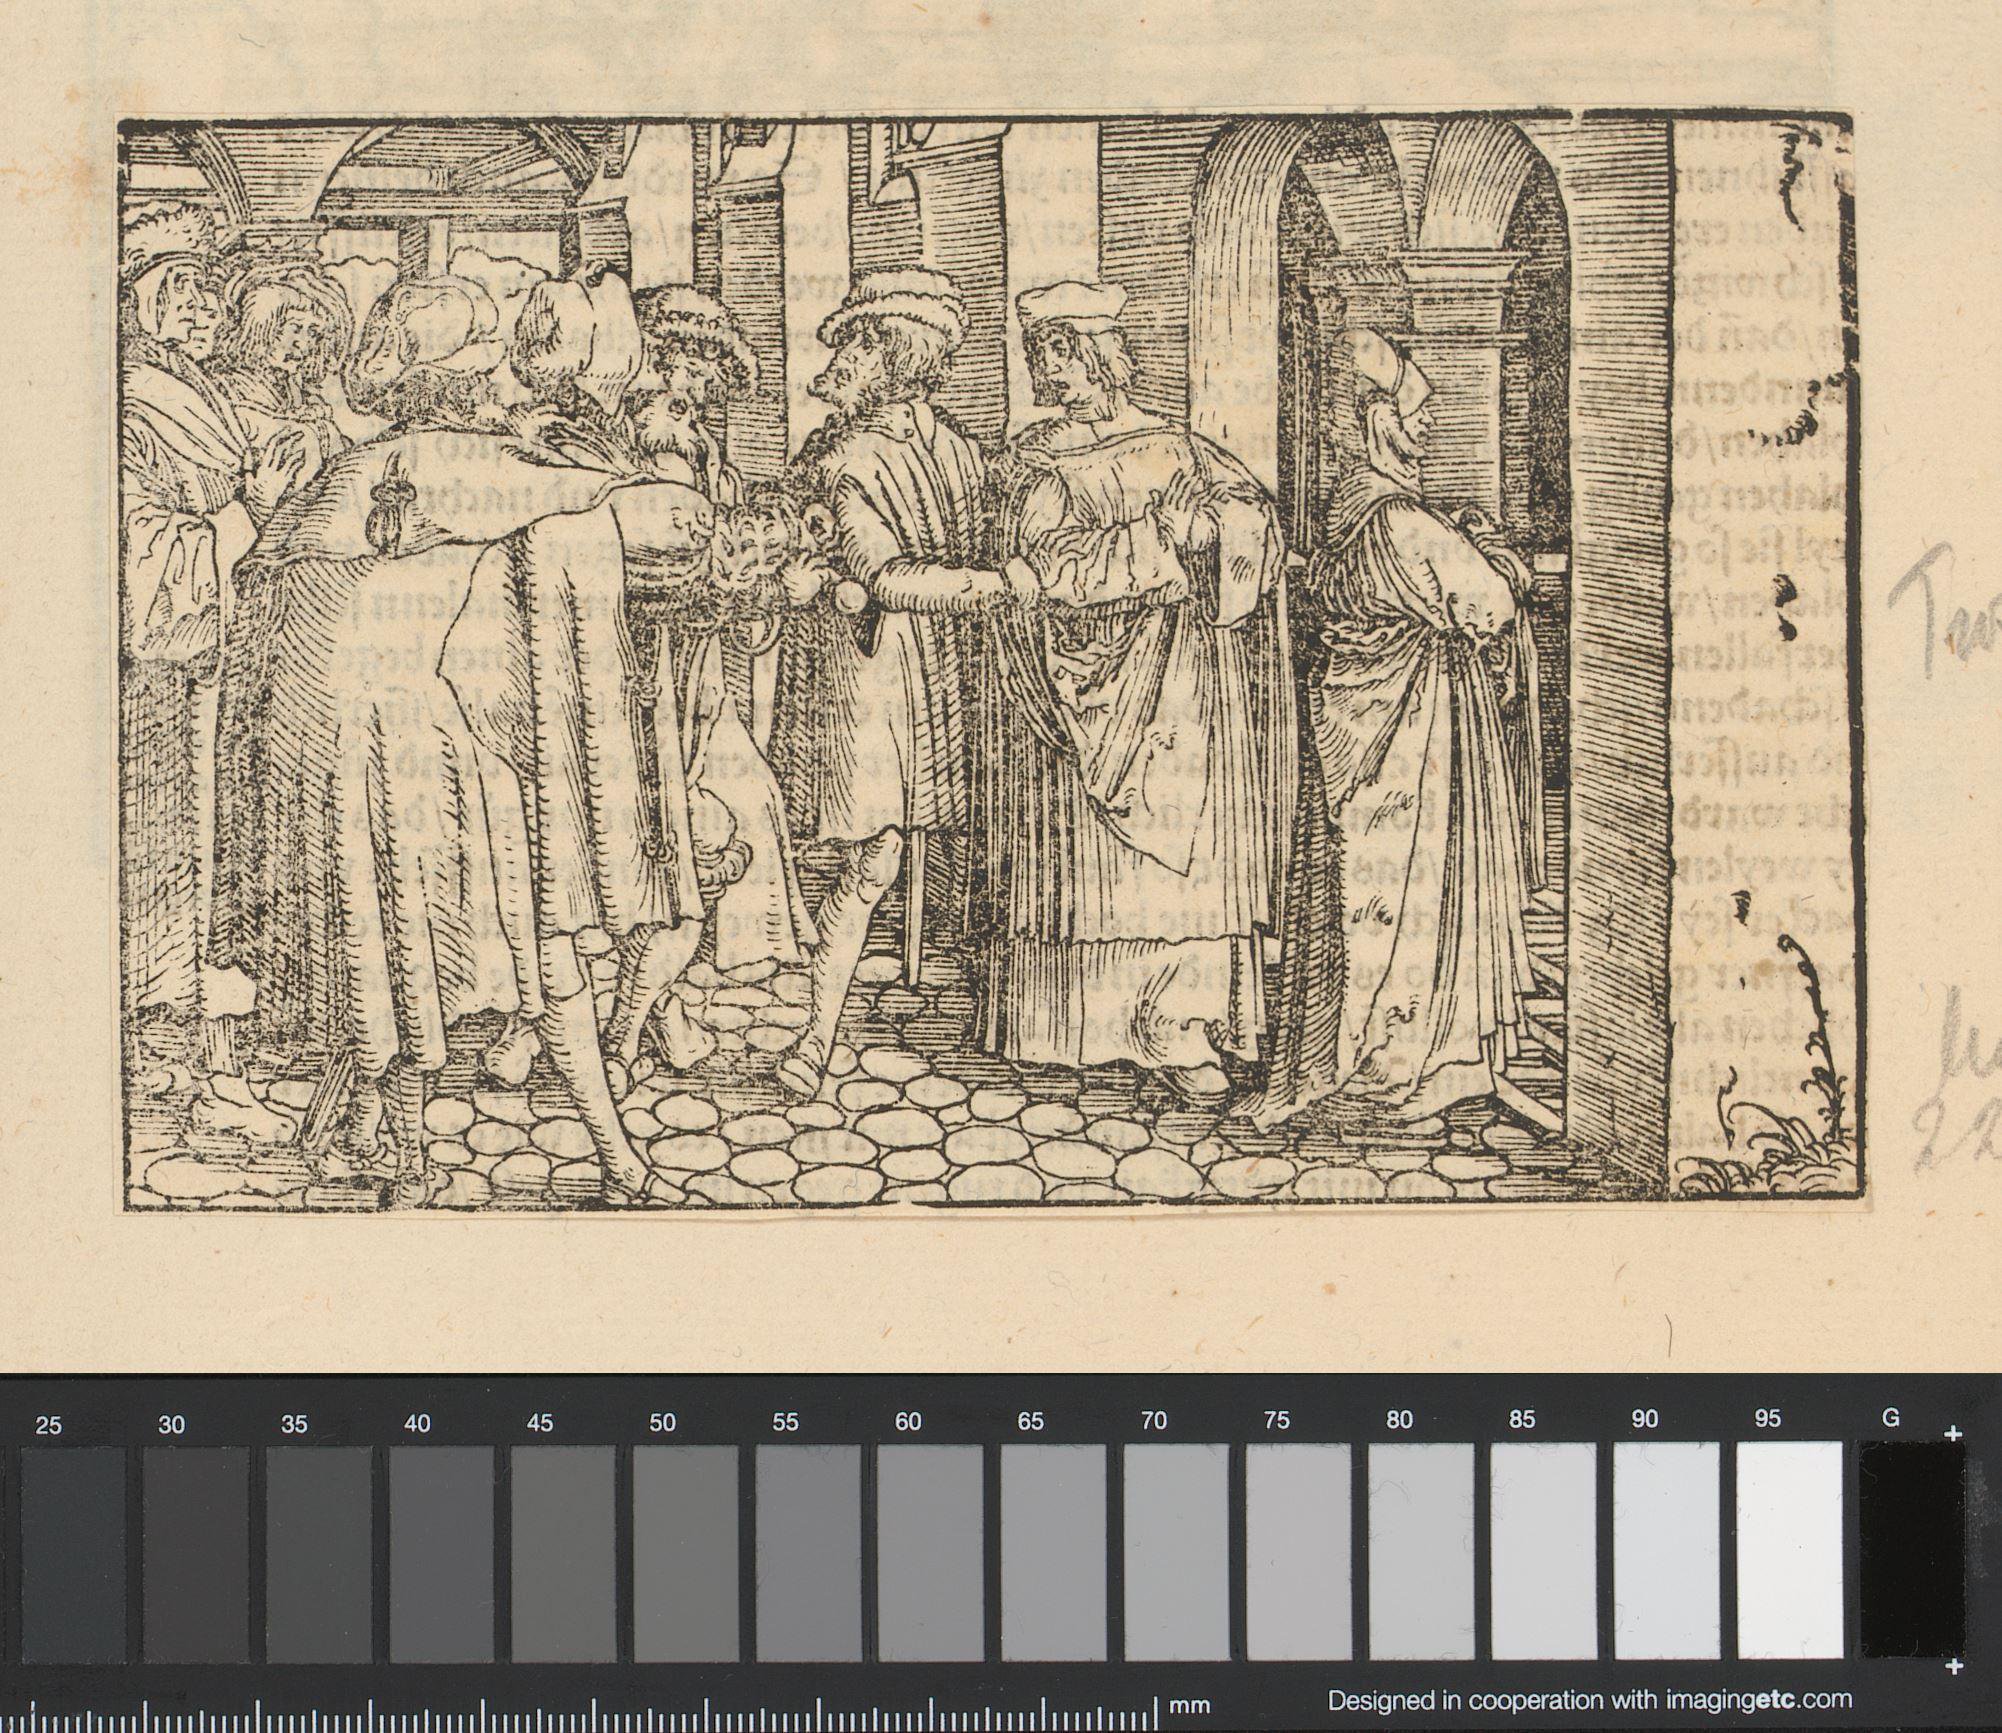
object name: album leaf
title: Tumult tijdens een processie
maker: Anonymous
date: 1514-1532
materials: paper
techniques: letterpress printing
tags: public worship and liturgy of the christian churches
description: Deze prent is gebruikt in: Petrarca, Francesco. Von der Artzney bayder Glück, des guten und widerwertigen: unnd weß sich ain yeder inn Gelück und Unglück halten sol (...). Augsburg: Heinrich Steiner, 1532. Deze uitgave is ook bekend onder de titel 'Trostspiegel in Glück und Unglück'.